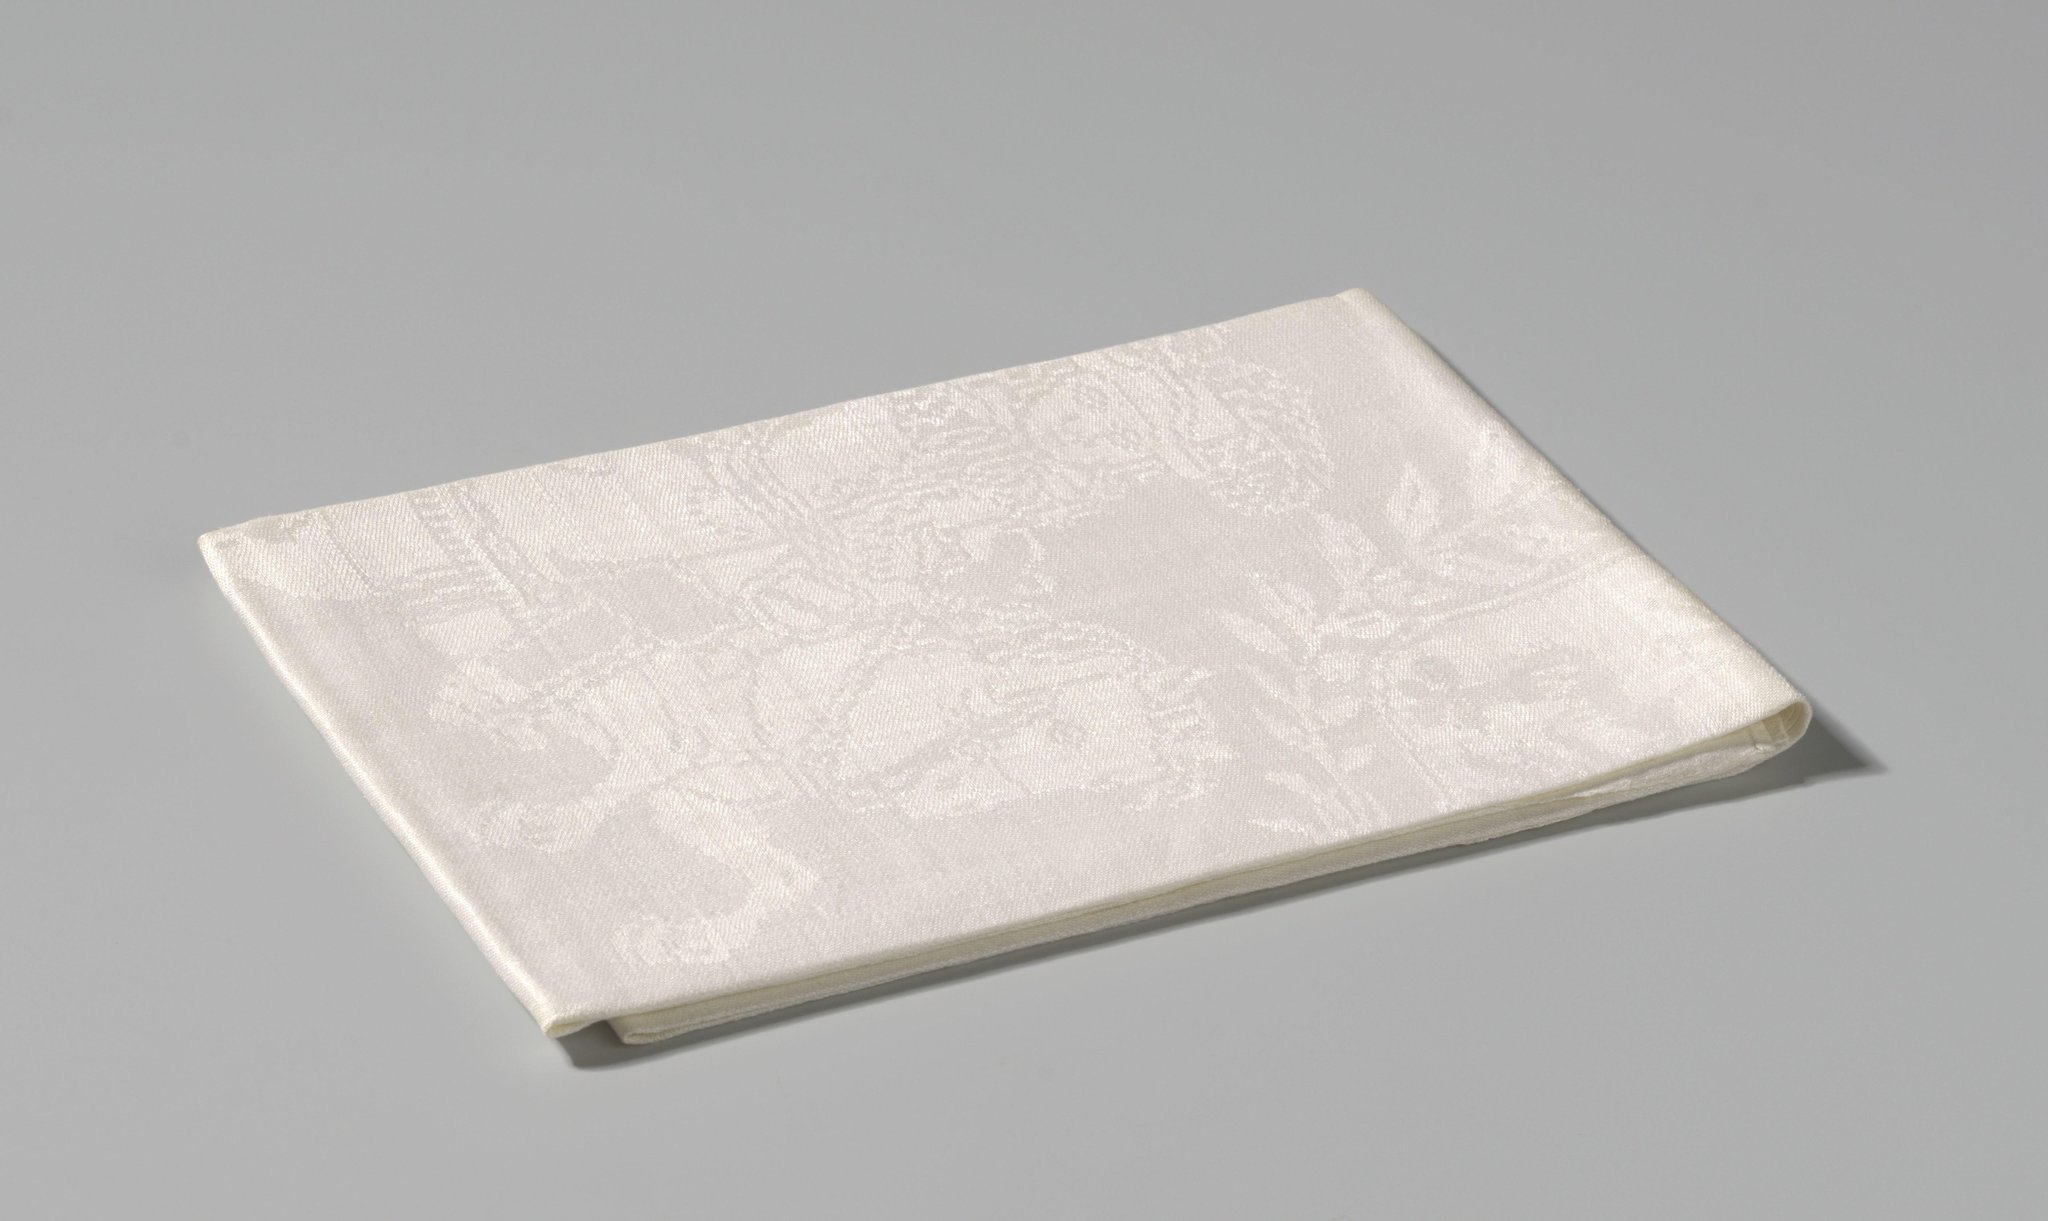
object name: napkin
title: Servet met de verovering van Neuhäusel, Gran, Buda en Pest door Leopold I, keizer van Duitsland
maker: Anonymous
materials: linen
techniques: damask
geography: flanders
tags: vienna, leopold i (keizer van duitsland)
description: Servet van linnendamast met de verovering van Neuhäusel, Gran, Buda en Pest door Leopold I; met het wapen van het Heilige Roomse Rijk met hartschild Oosterijk.